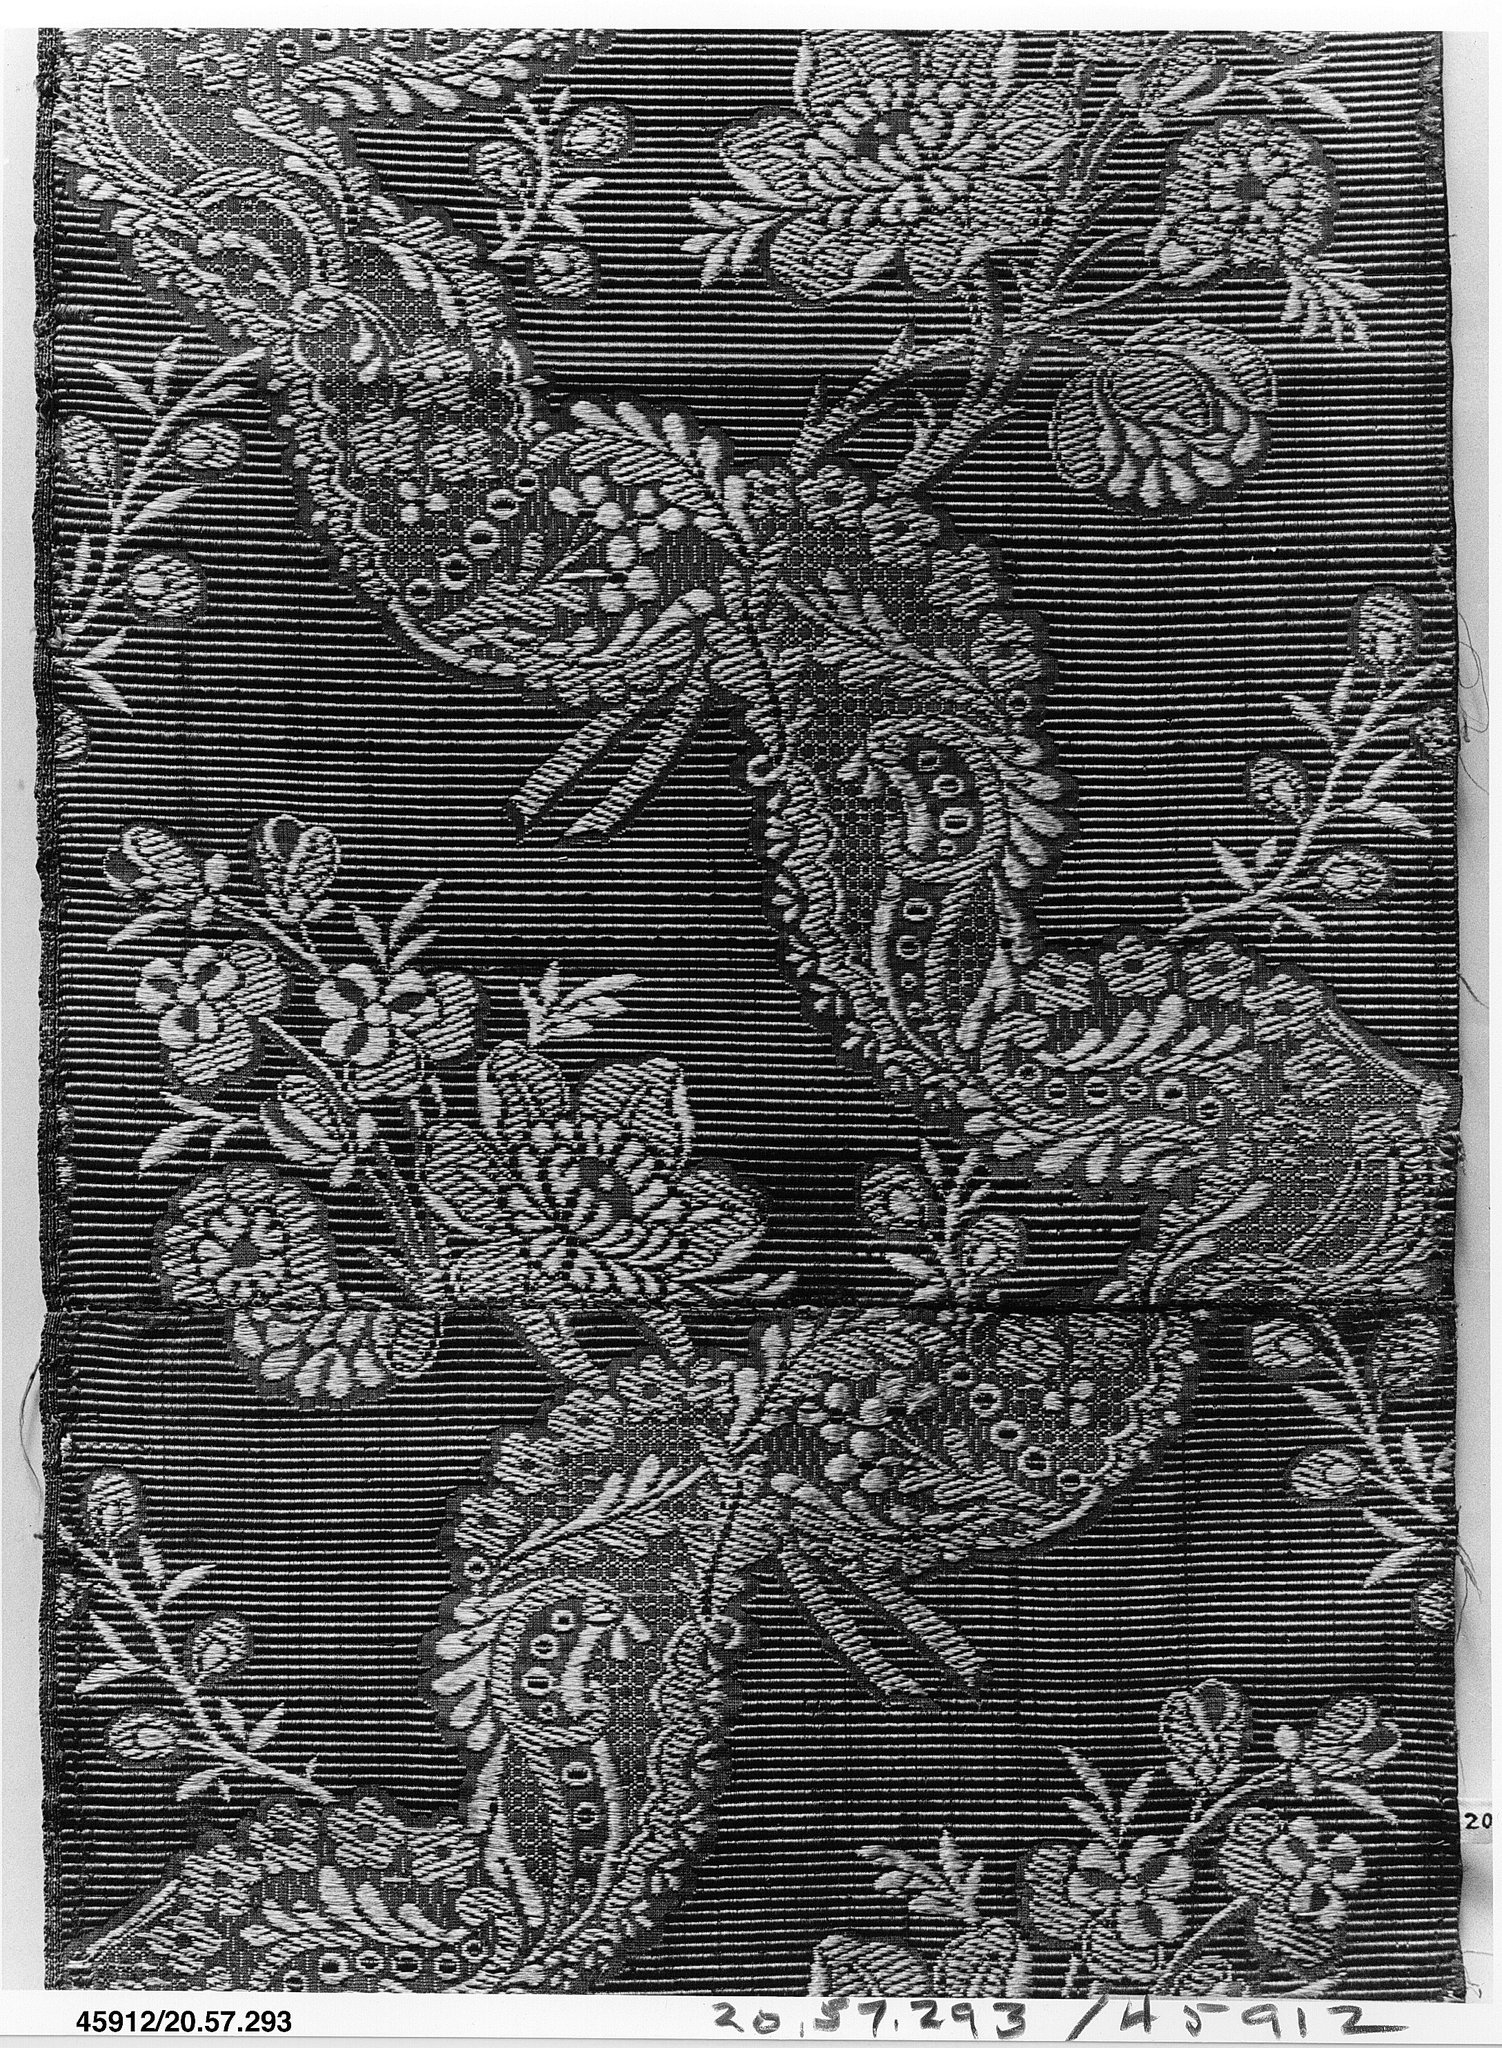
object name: piece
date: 1750-1760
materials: silk